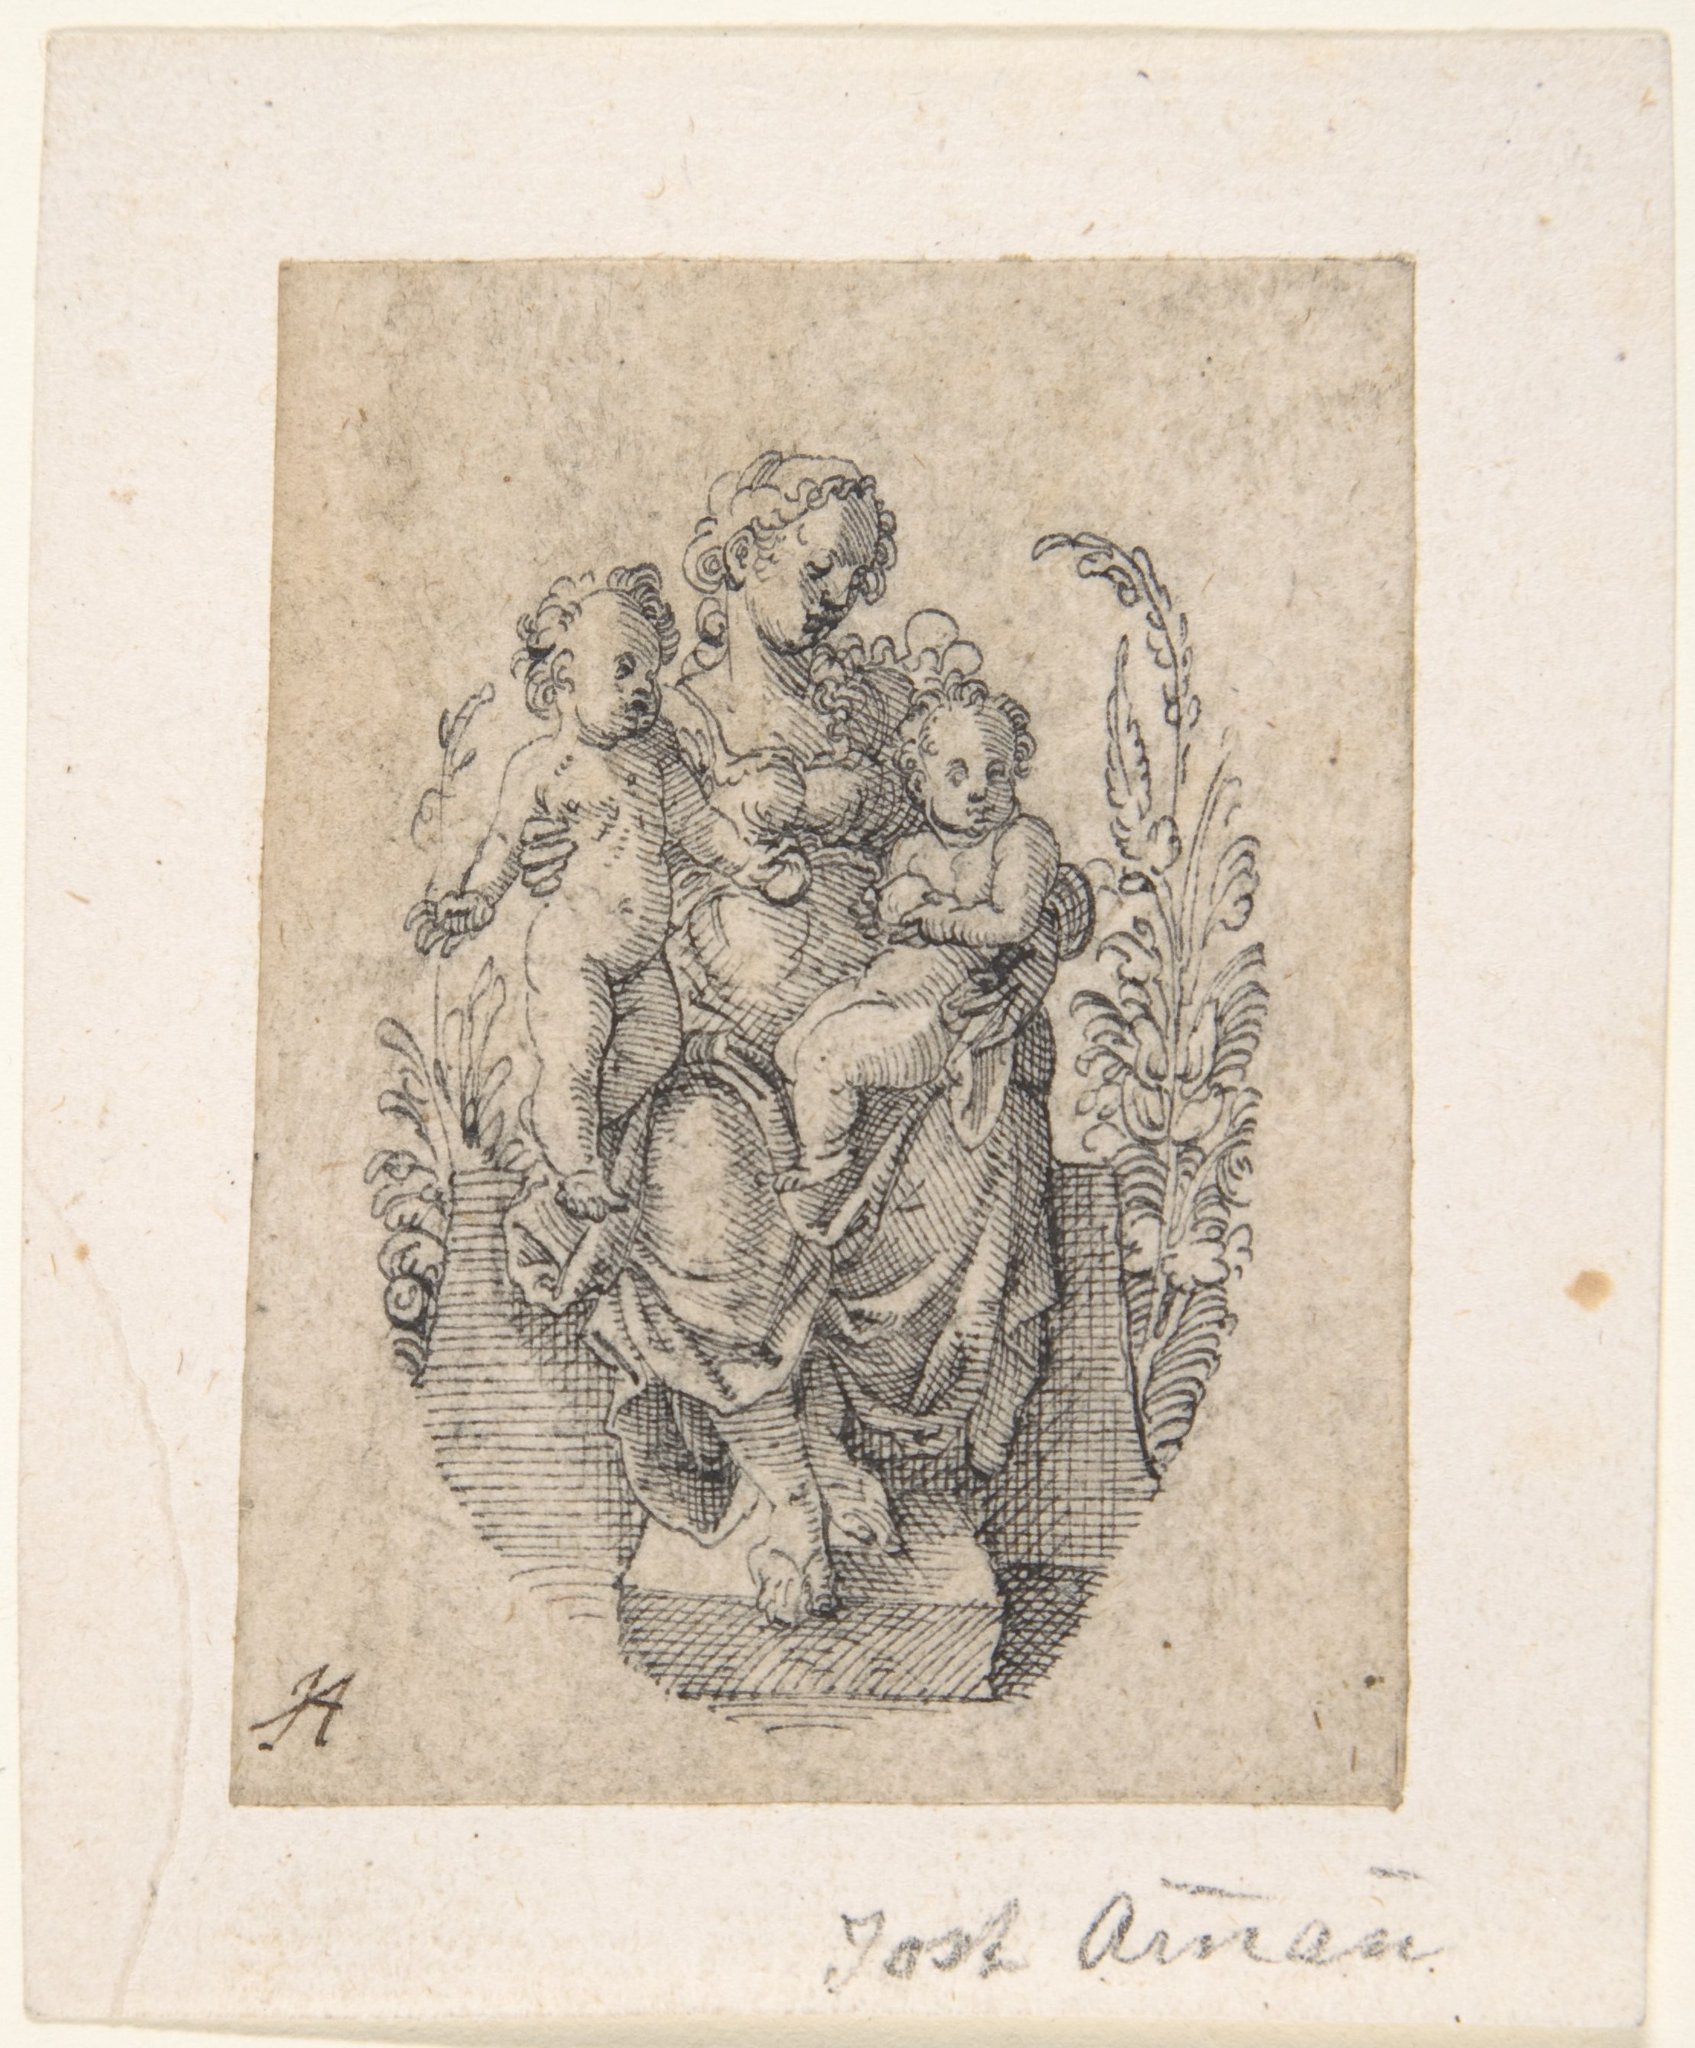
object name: drawing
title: A Seated Personification of Charity with two Children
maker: jost amman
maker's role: artist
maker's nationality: swiss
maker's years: 1539-1591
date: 1539-1591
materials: ink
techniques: pen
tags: children,women